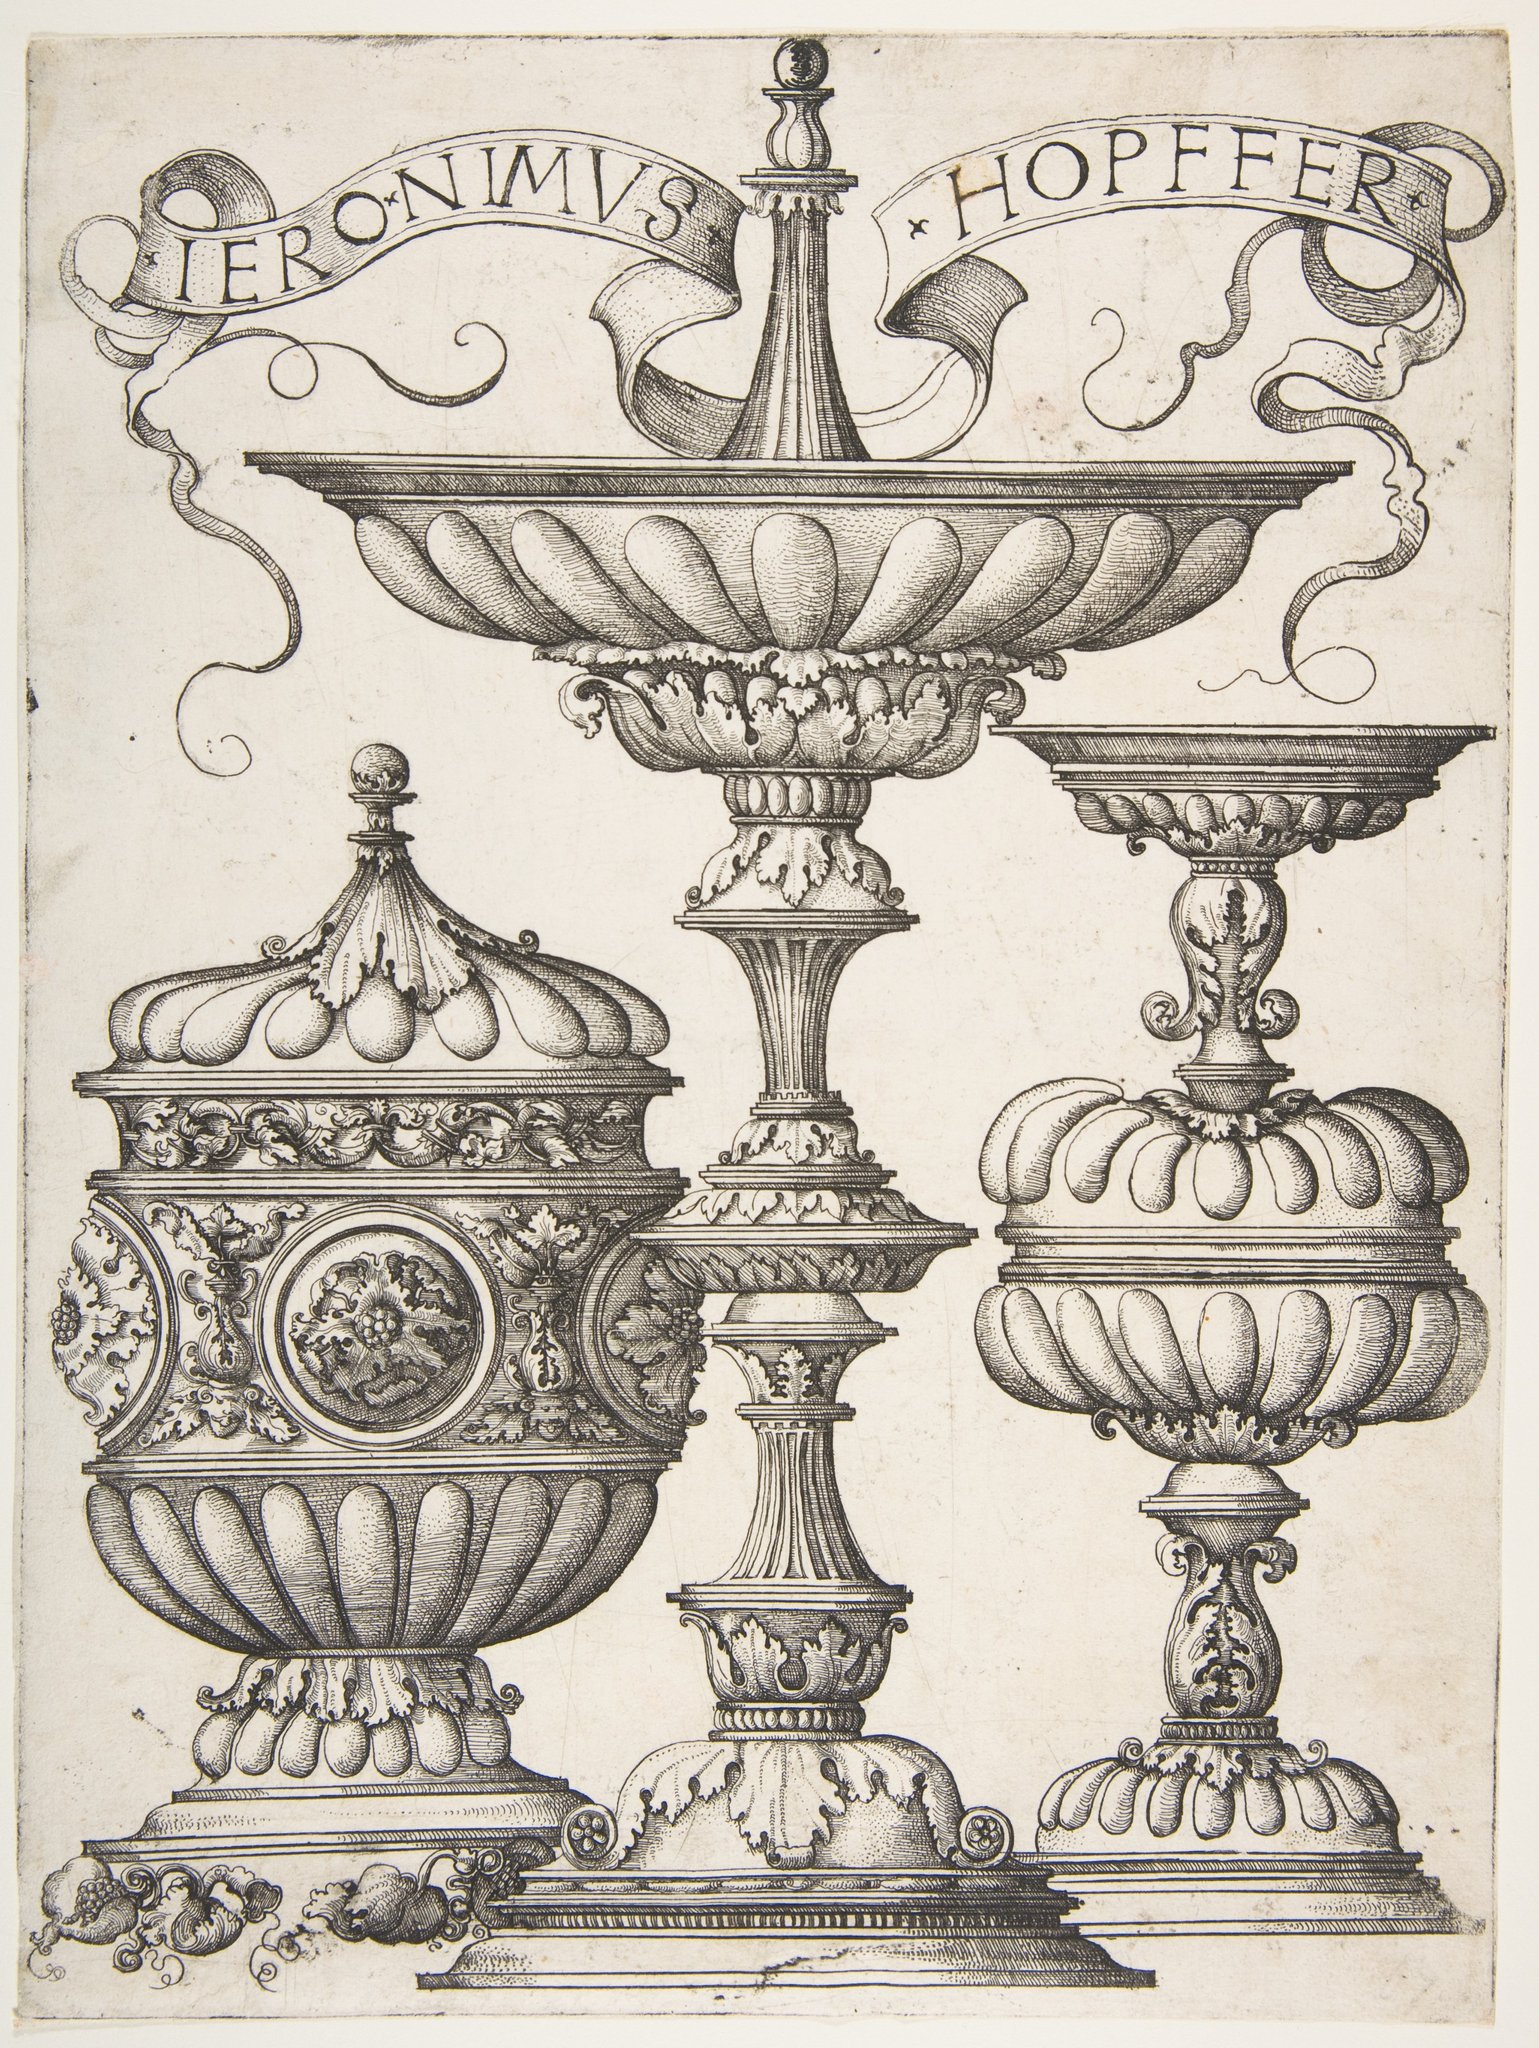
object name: collection ornament architecture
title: Three Vessels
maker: hieronymus hopfer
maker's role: artist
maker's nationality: german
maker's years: 1500-1563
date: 1501-1600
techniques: etching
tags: vessels